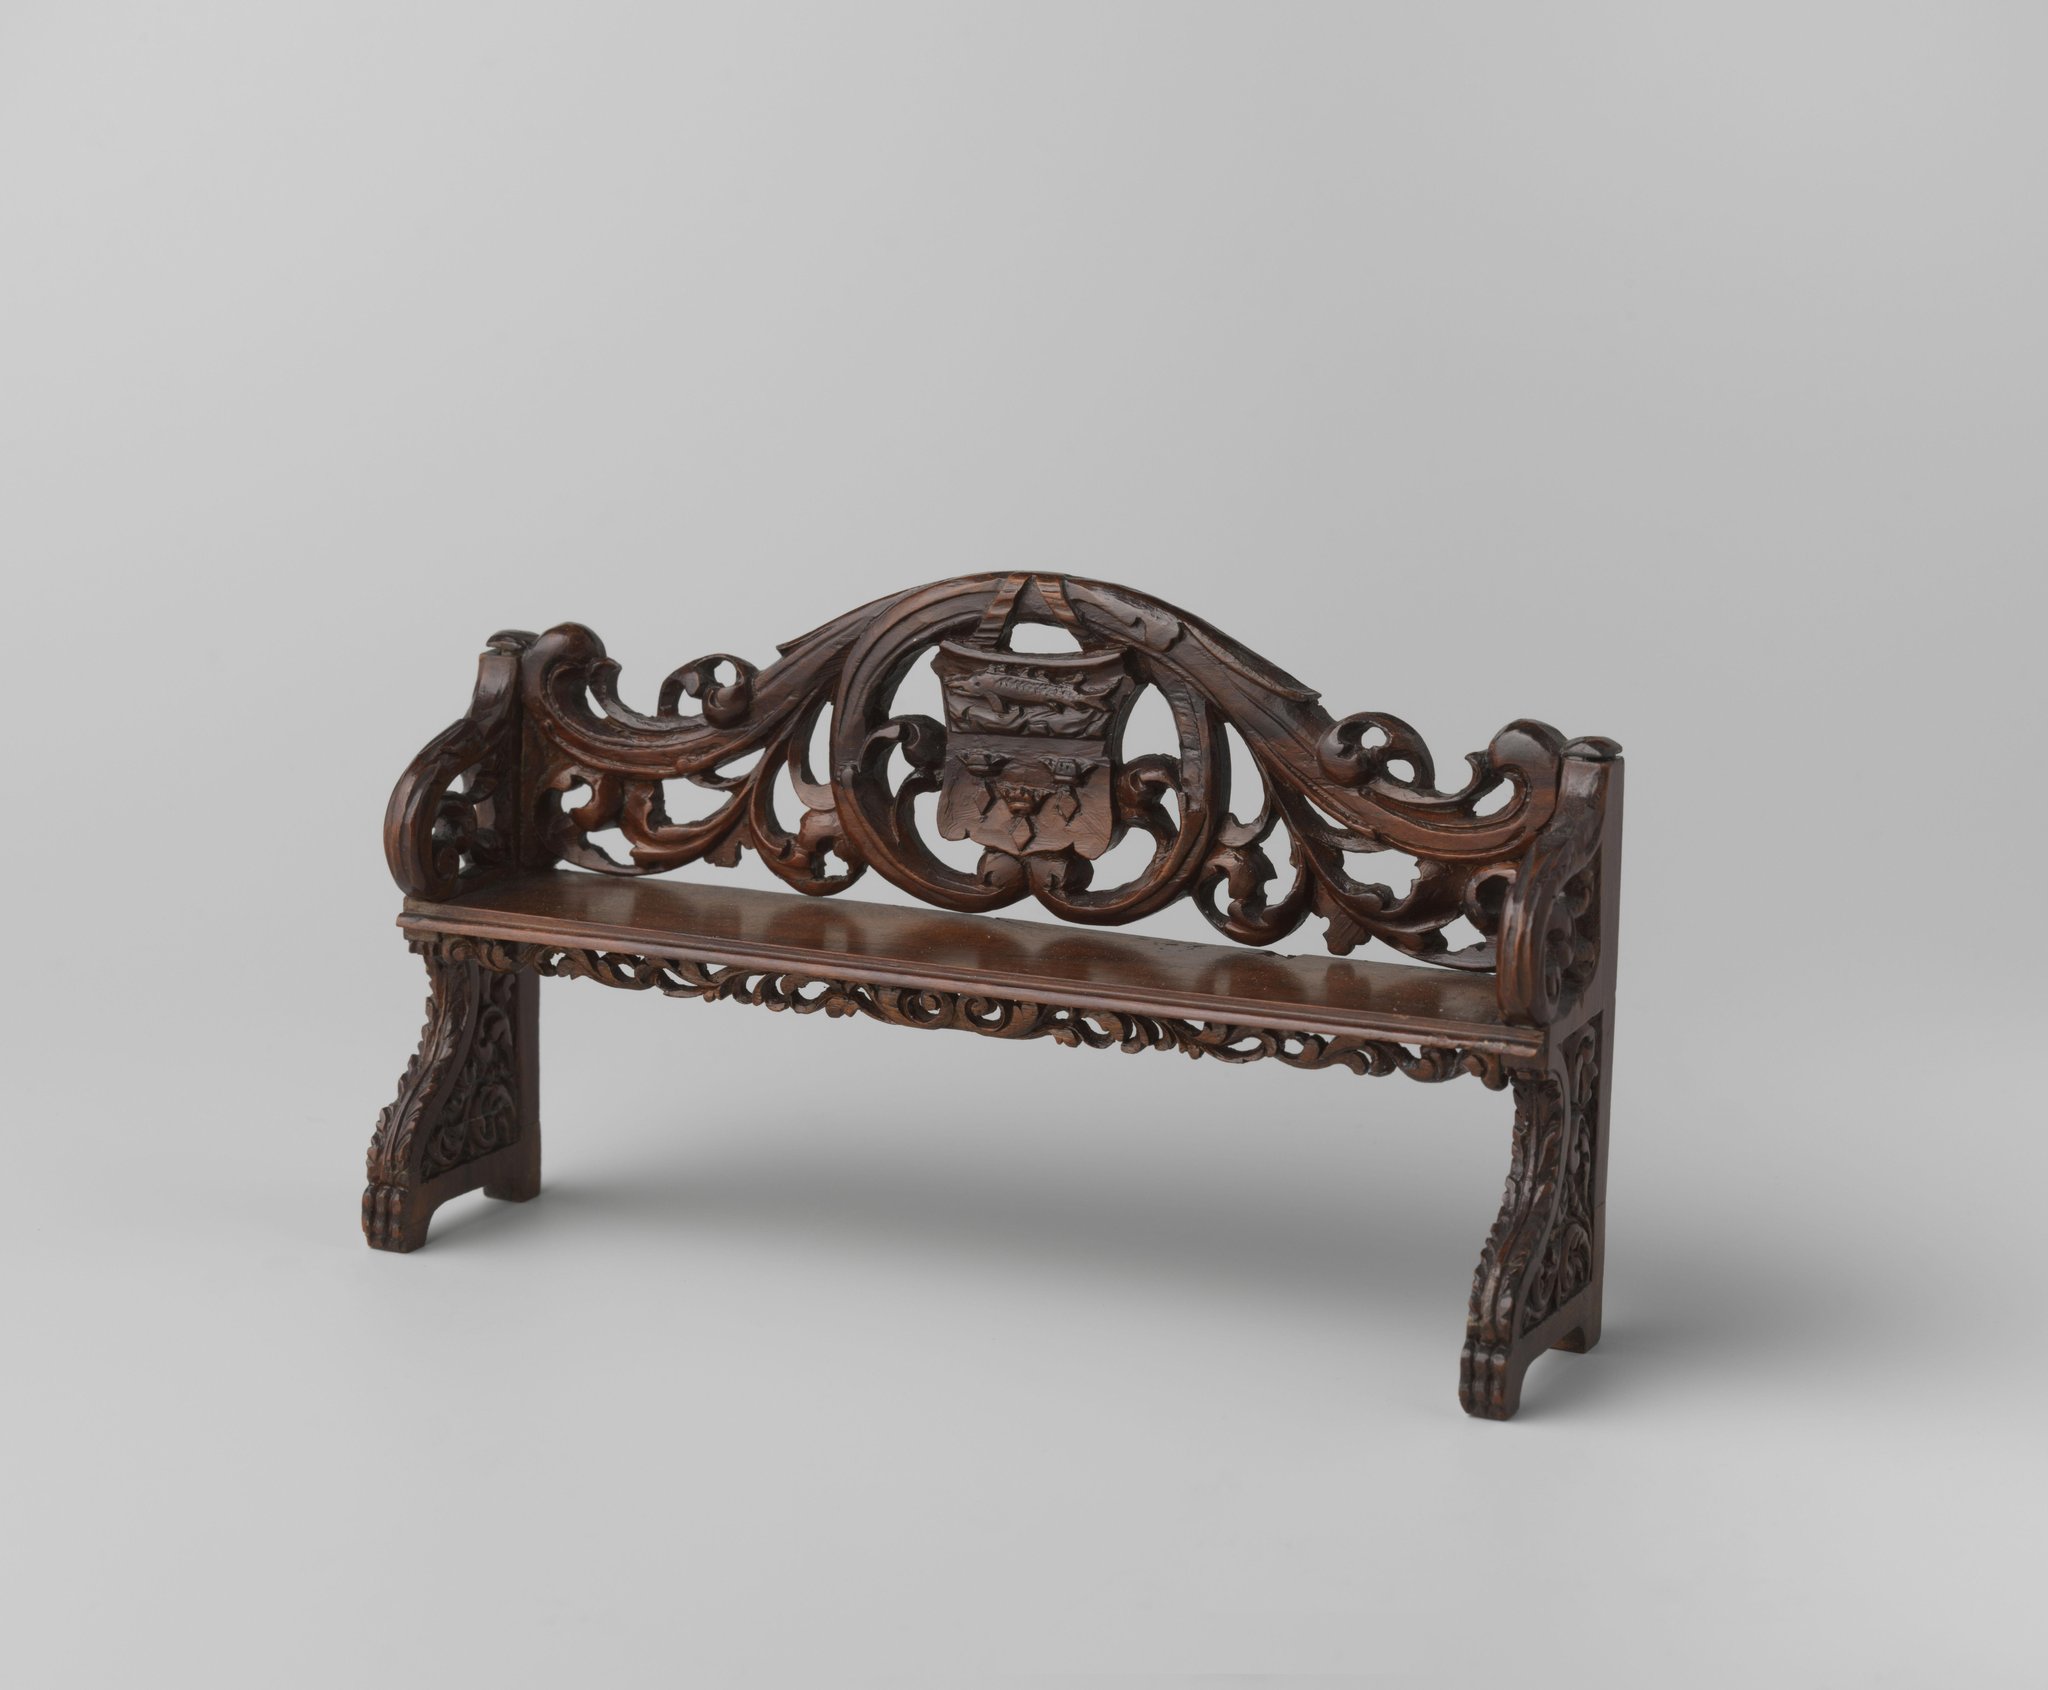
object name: hall seat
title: Gangbank vervaardigd van olijfhout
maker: Anonymous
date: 1690-1710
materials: wood